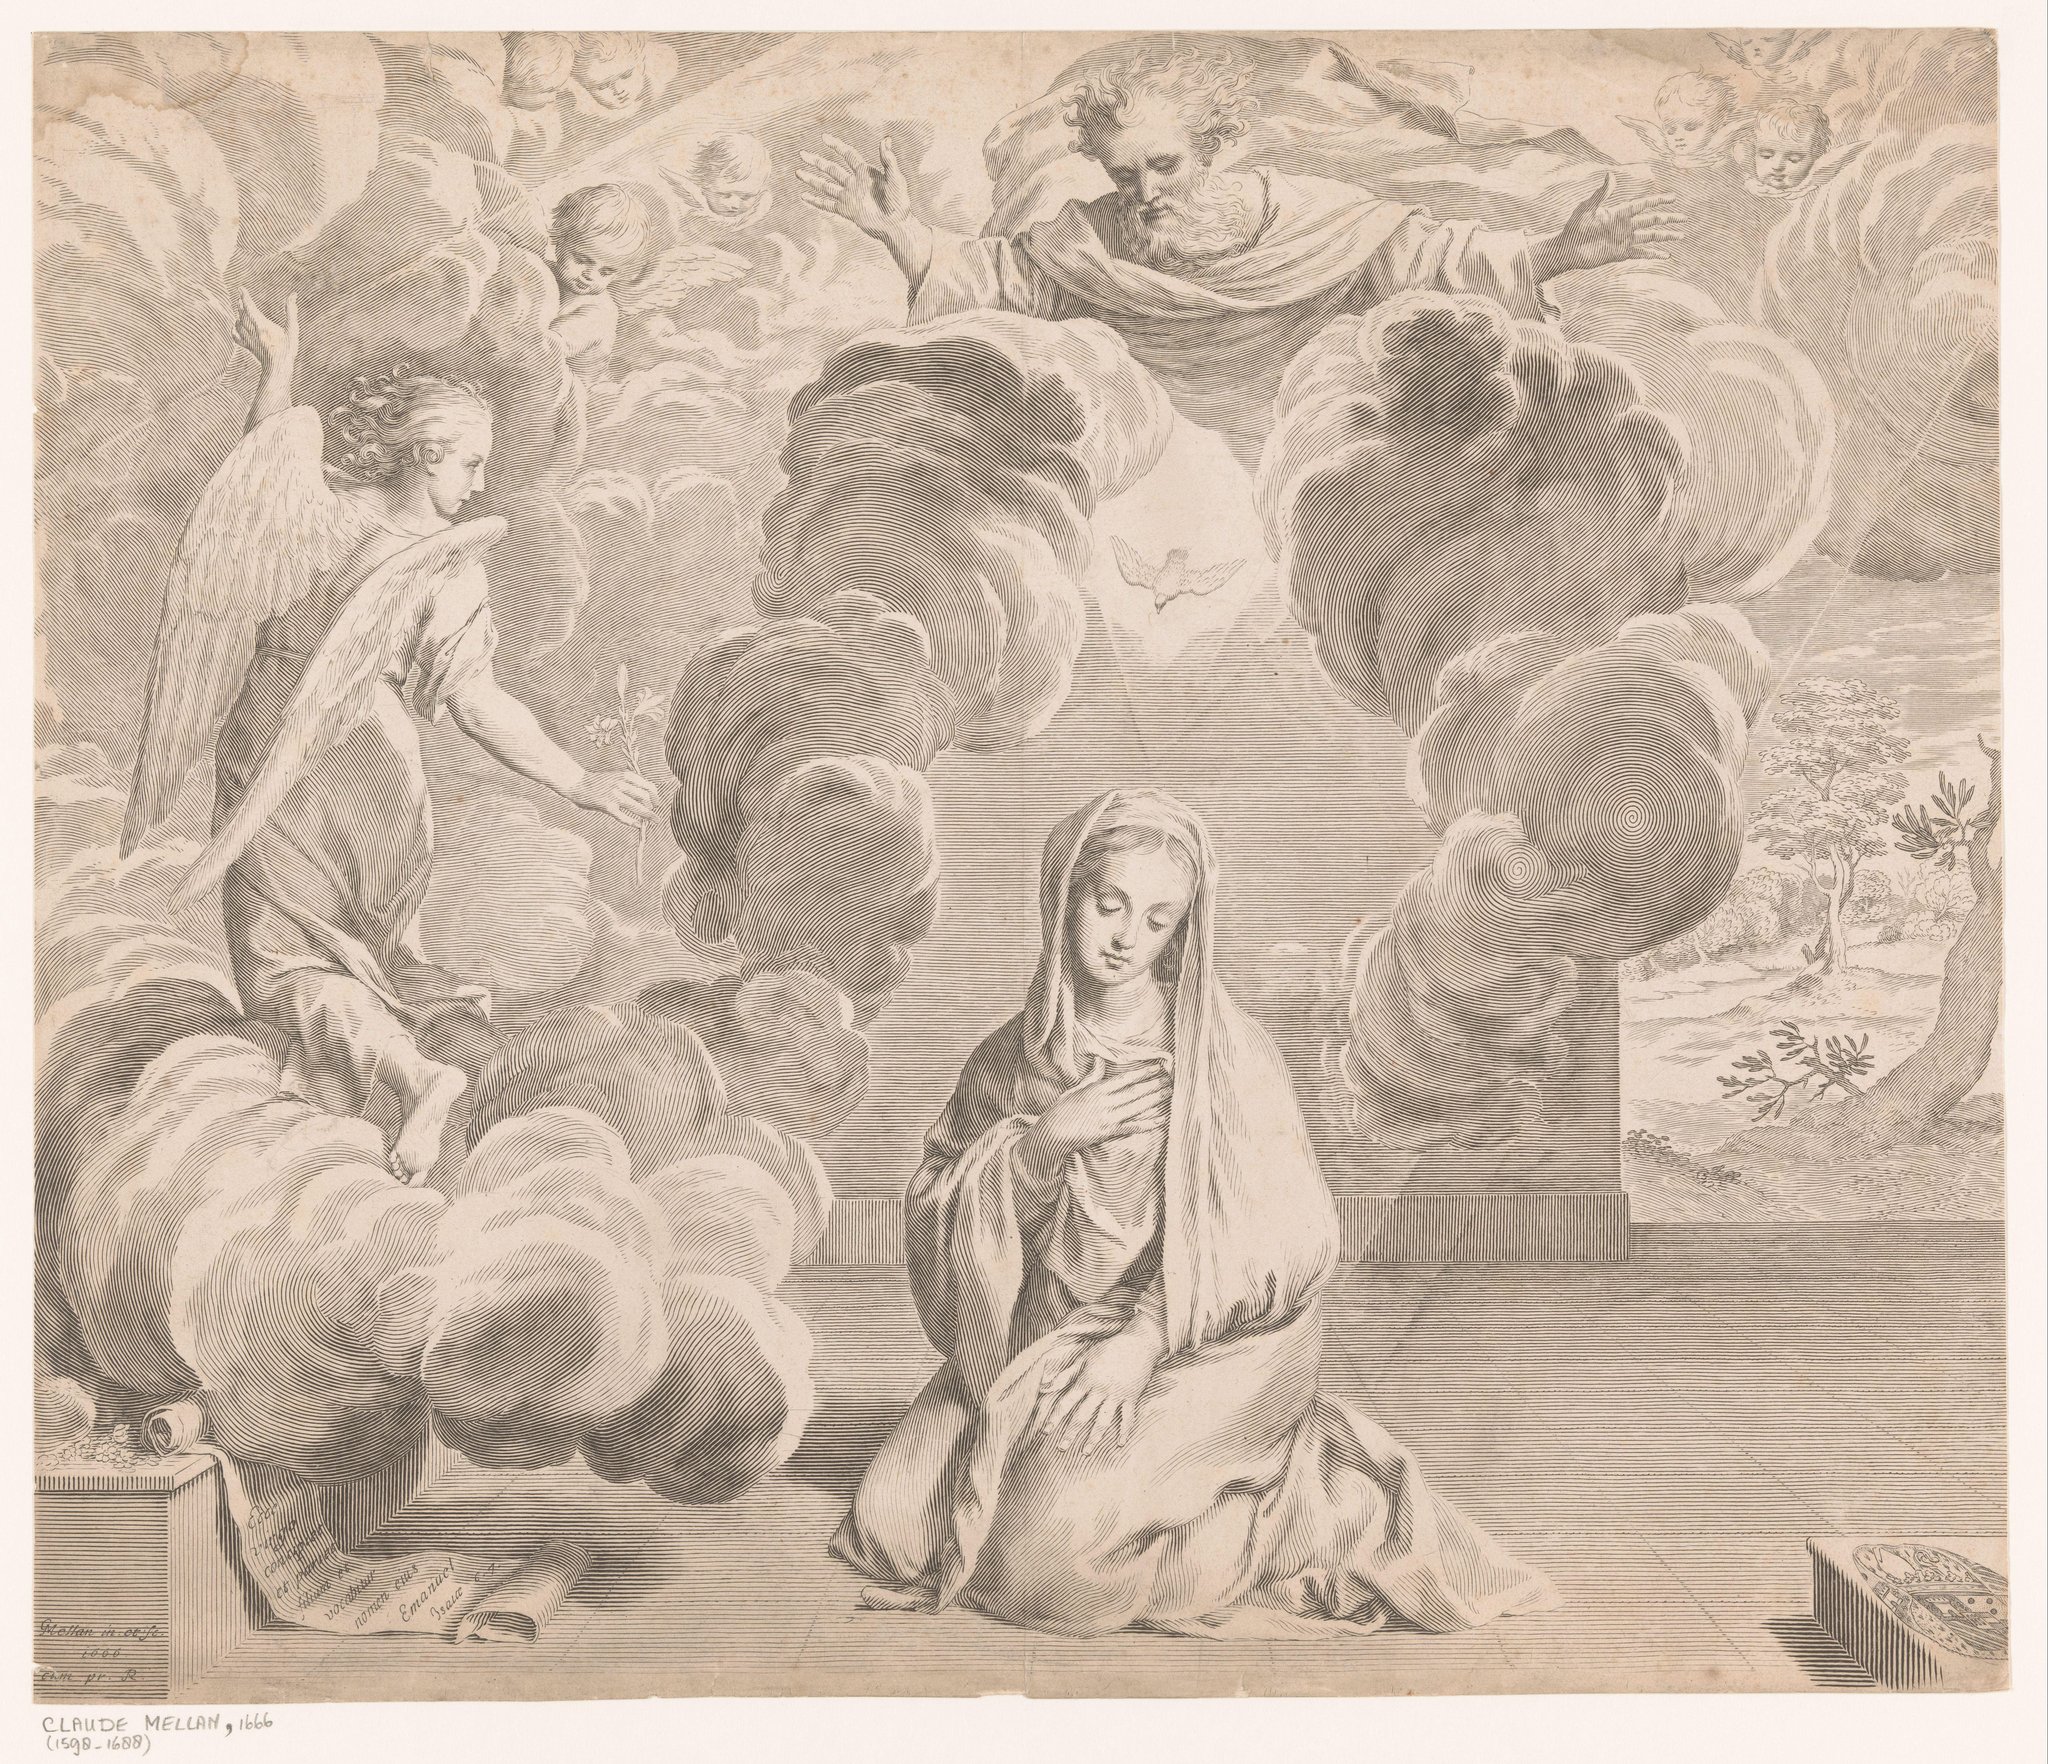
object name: print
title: Annunciatie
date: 1666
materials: paper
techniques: engraving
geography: france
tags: the annunciation: mary, usually reading, is visited by the angel (sometimes a woman overhears the conversation)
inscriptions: collector's mark: Lugt 2228, inscription: ‘Claude [...]’